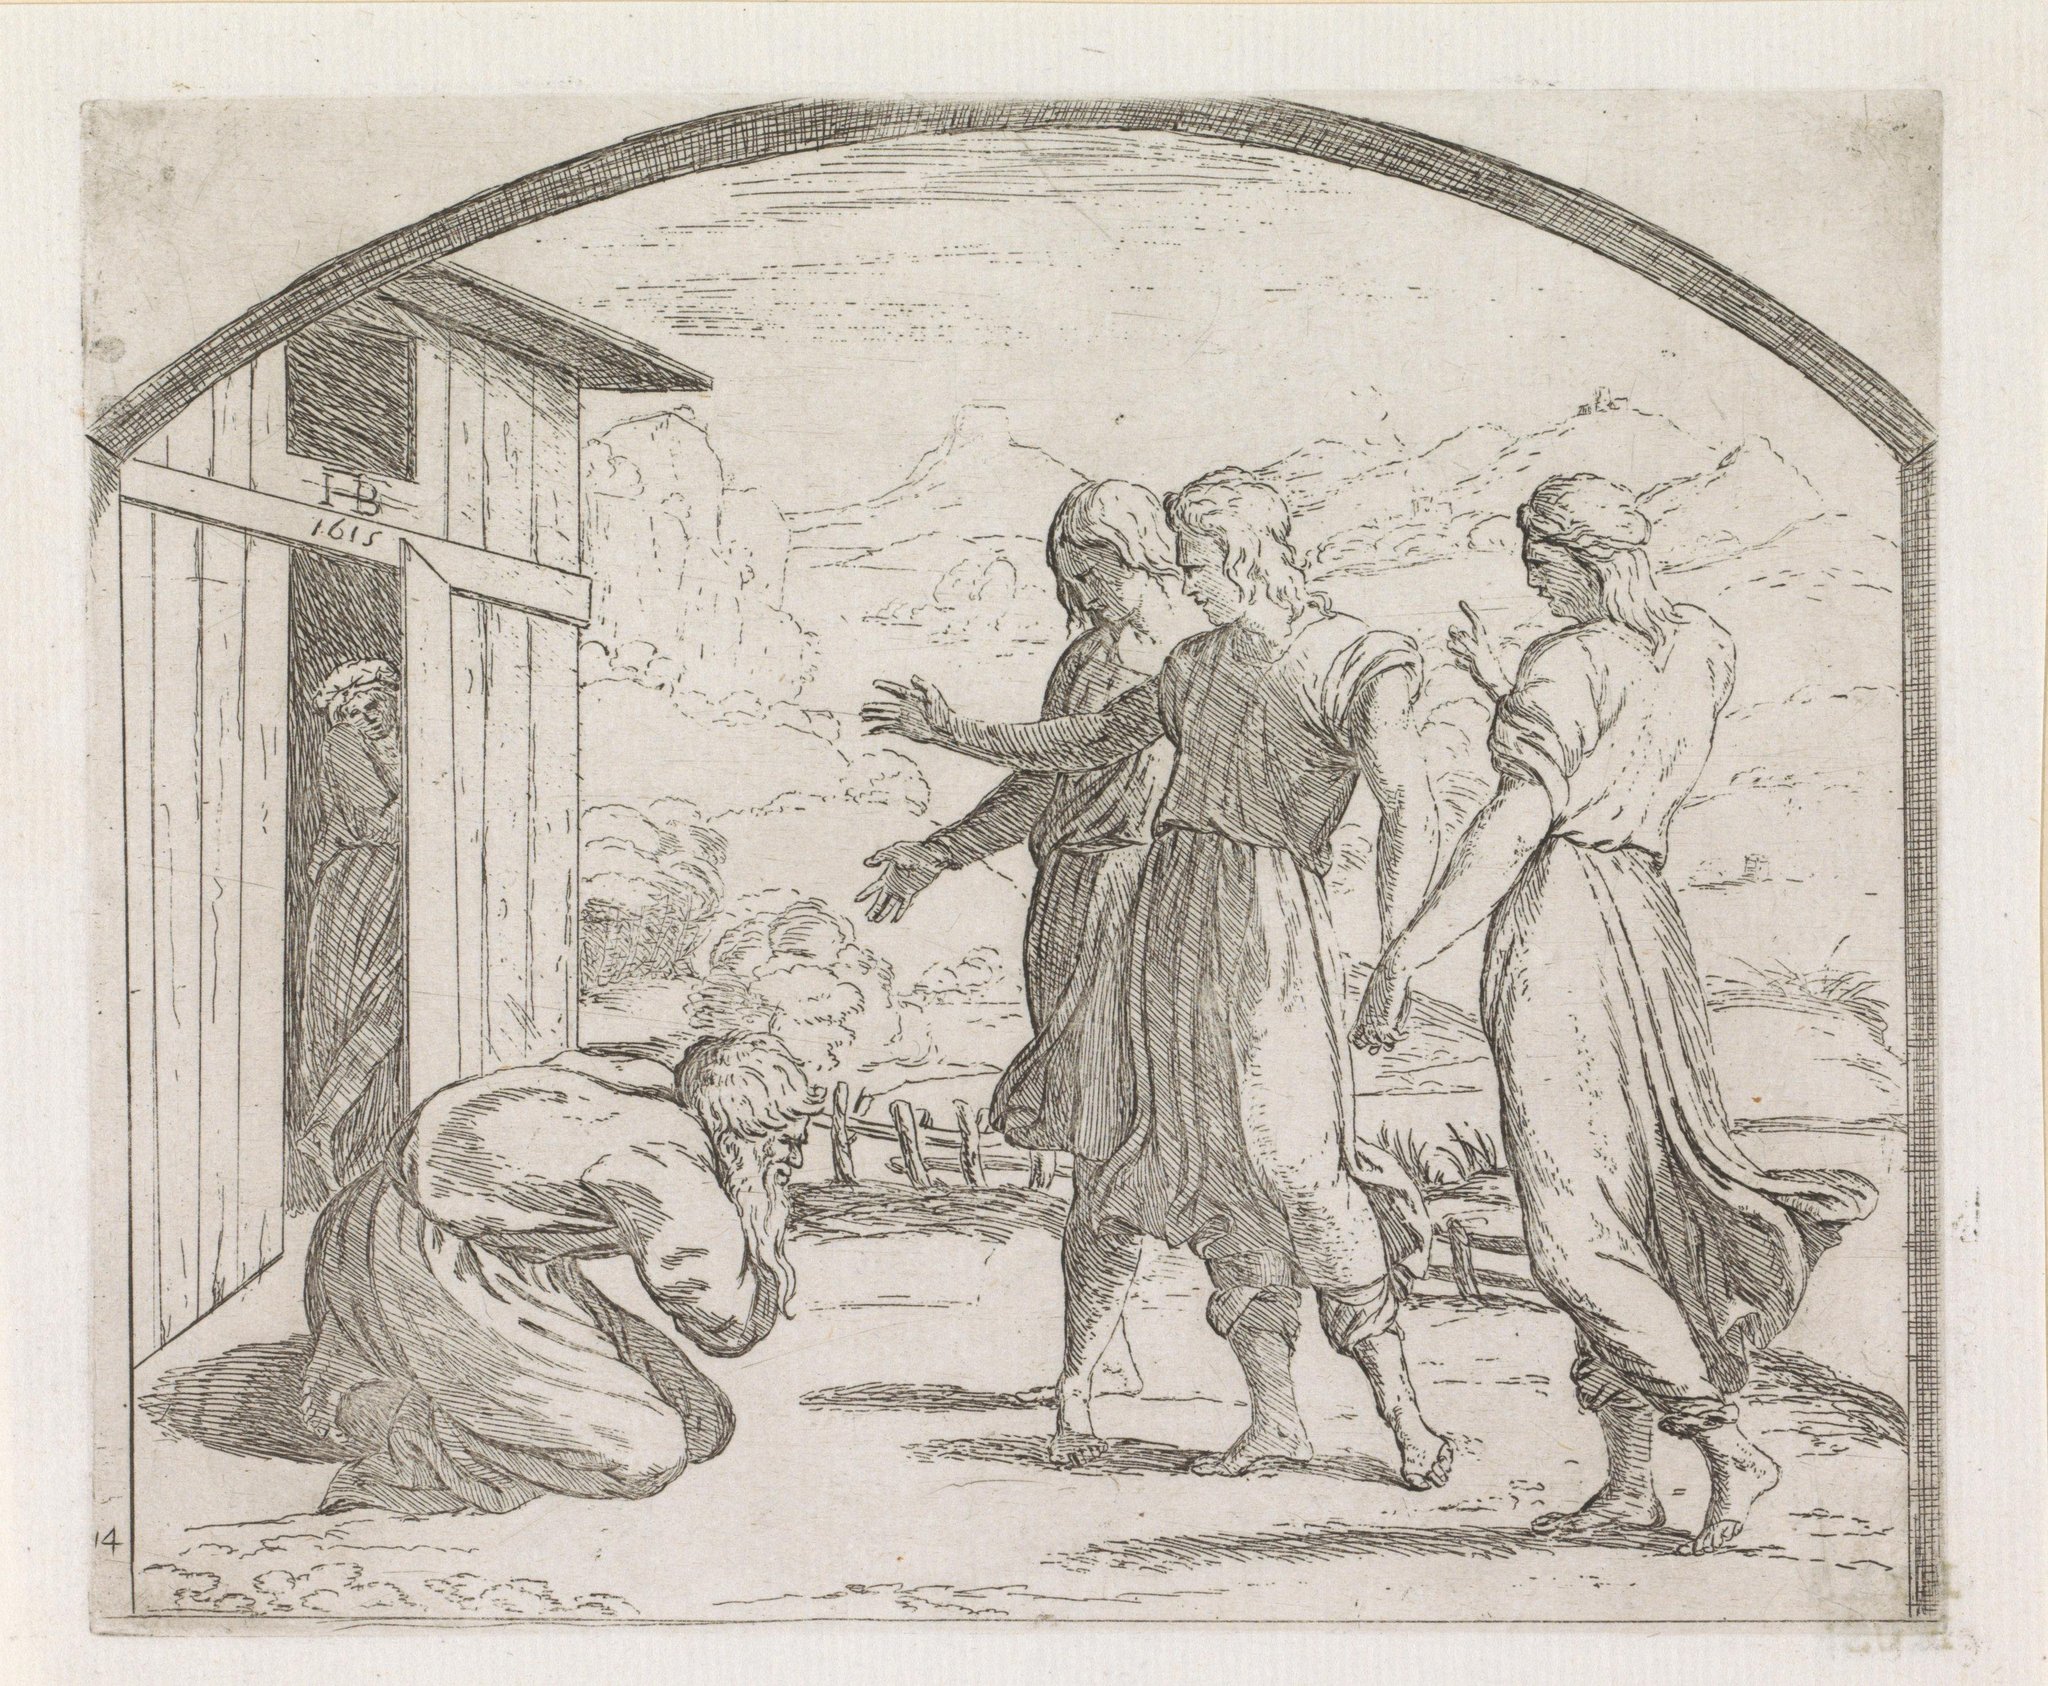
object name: print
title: Abraham en de drie engelen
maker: orazio borgianni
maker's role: print maker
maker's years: 1578-1616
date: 1615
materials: paper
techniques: etching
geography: italy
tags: abraham kneels before the angels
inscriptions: collector's mark: Lugt 2165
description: Prent uit een reeks van 52 prenten naar schilderingen in de Loggia van Rafaël in het Vaticaan.